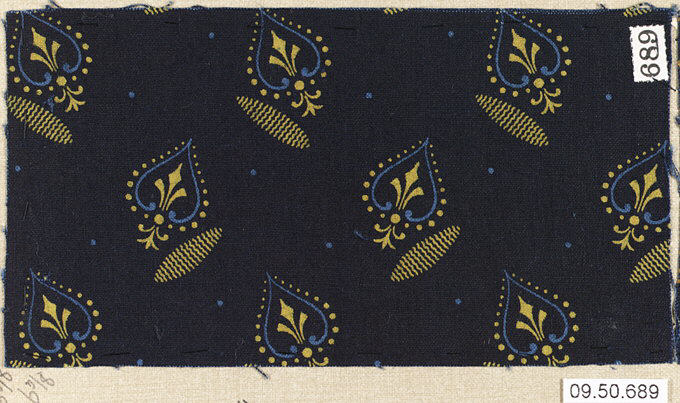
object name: piece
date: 1801-1900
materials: cotton